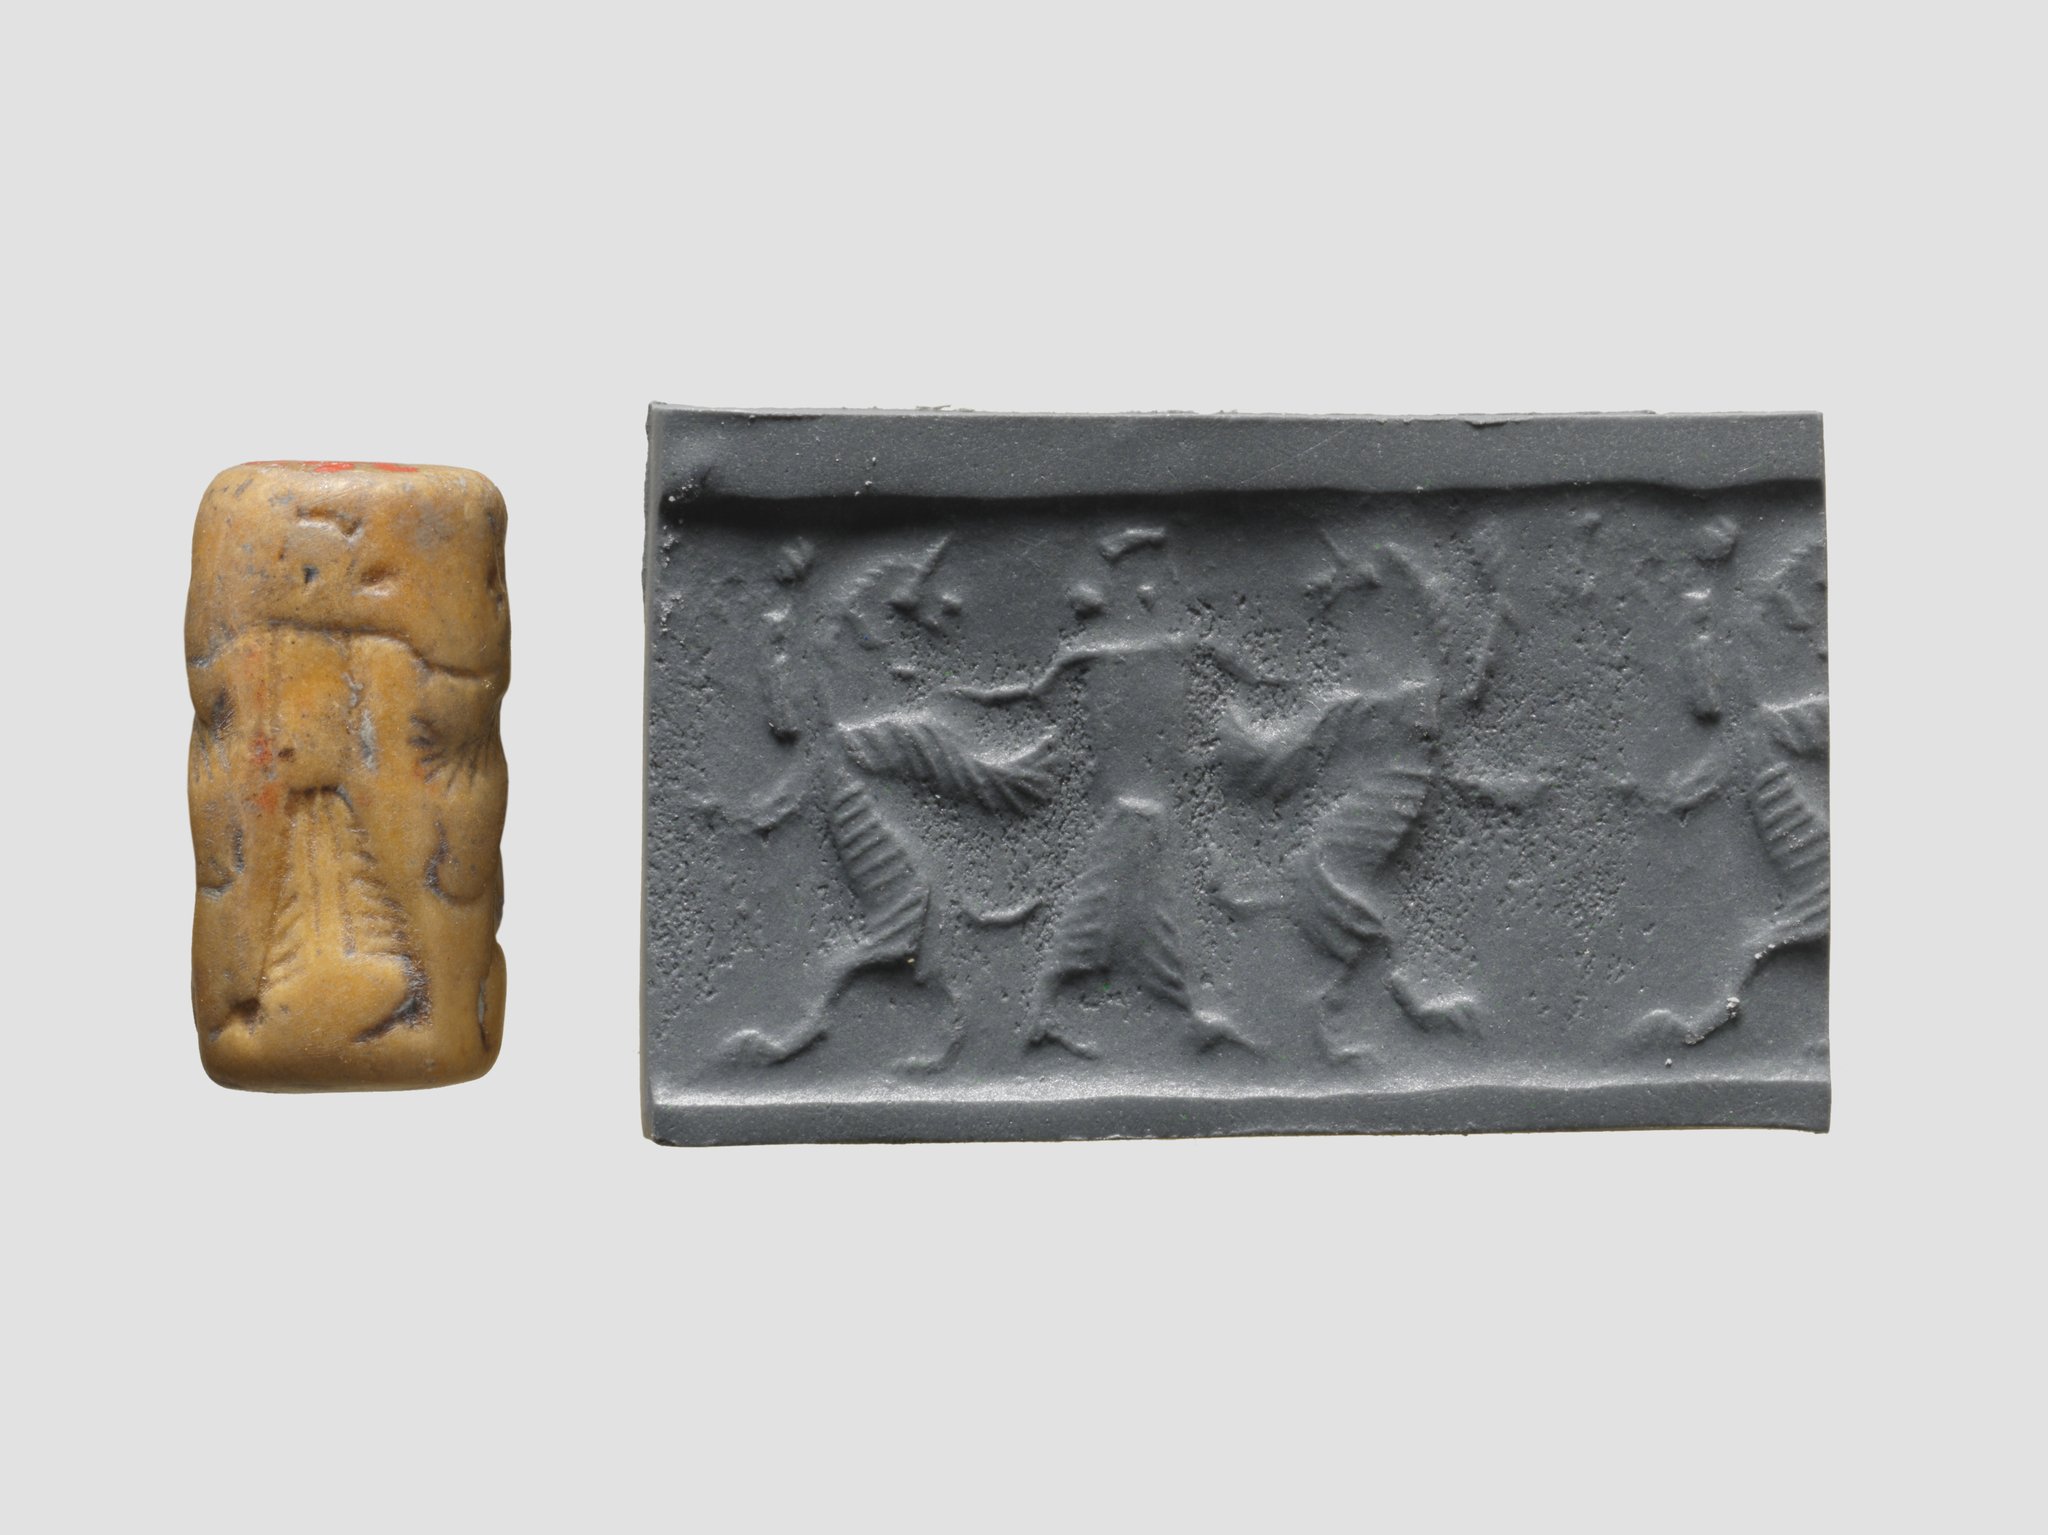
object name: cylinder seal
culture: achaemenid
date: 600-301 BCE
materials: limestone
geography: iran